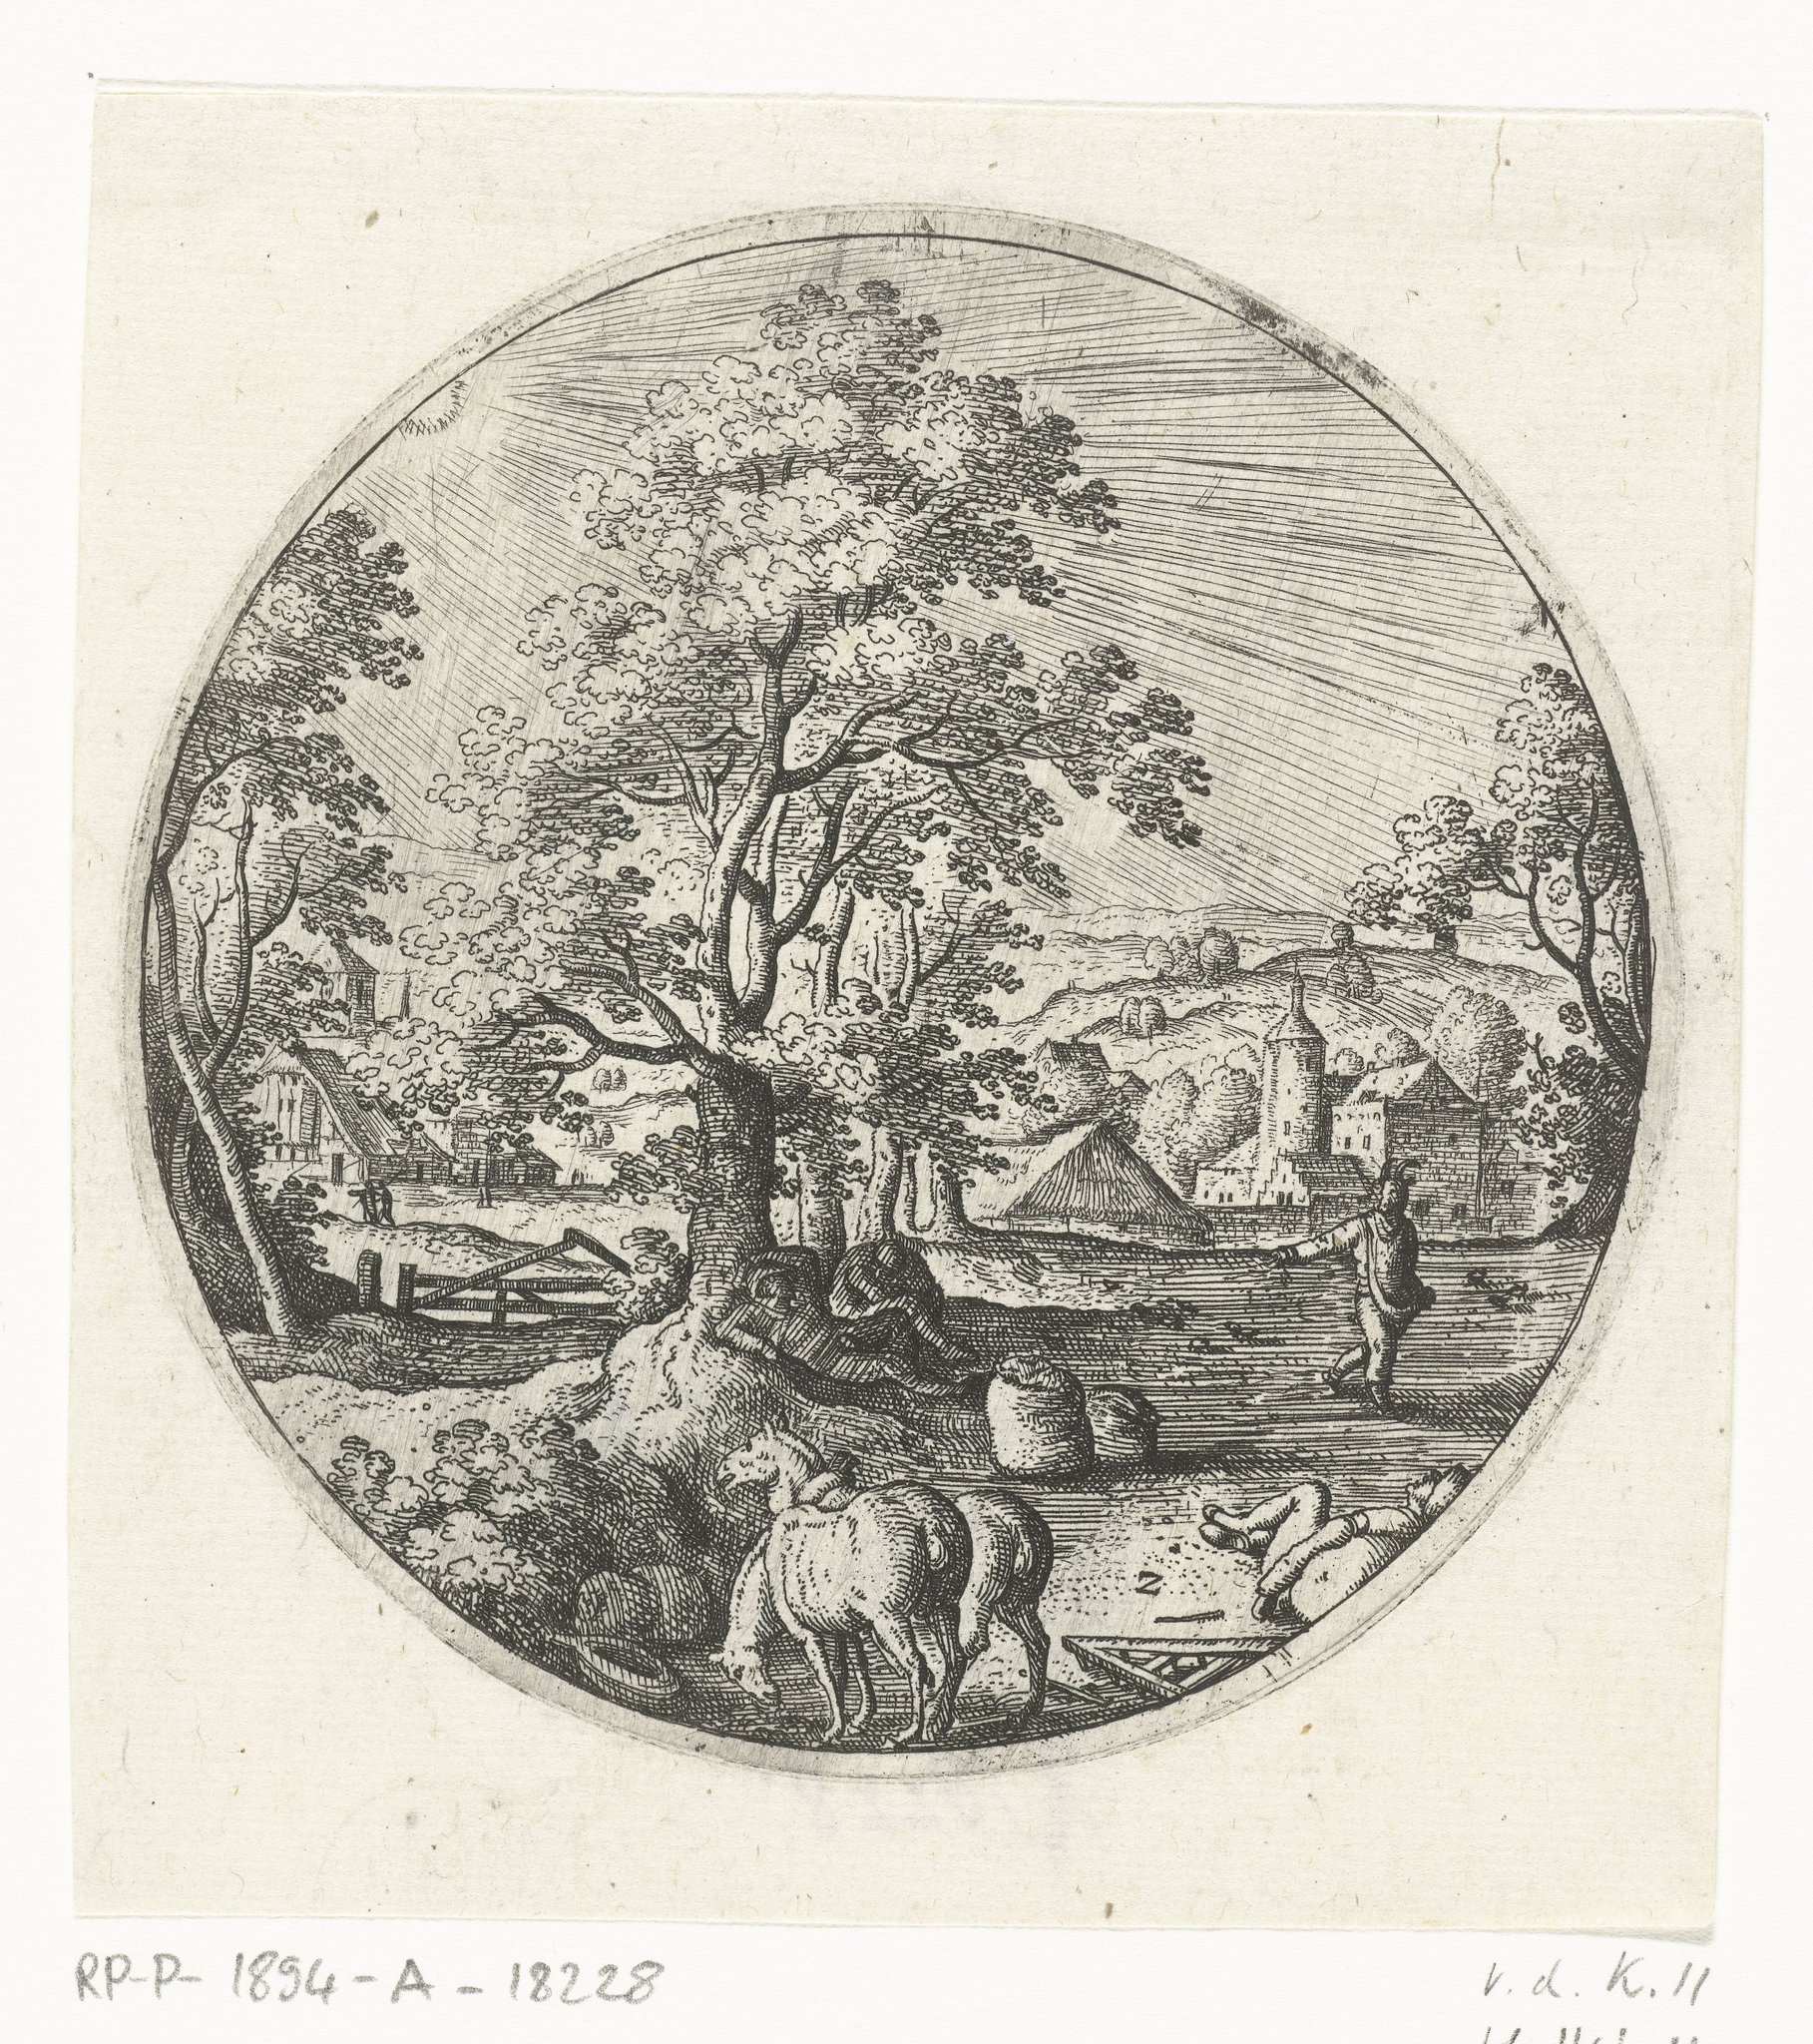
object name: print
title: De duivel zaait onkruid onder het graan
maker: hans bol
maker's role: draughtsman, print maker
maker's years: 1534-1593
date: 1574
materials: paper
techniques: etching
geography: southern netherlands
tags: while the sower and his servants slept, his enemy (the devil) sowed tares among the wheat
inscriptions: date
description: Terwijl de boer en zijn knechten onder een boom liggen slapen zaait de duivel onkruid op het veld waar zij net tarwe hebben gezaaid.